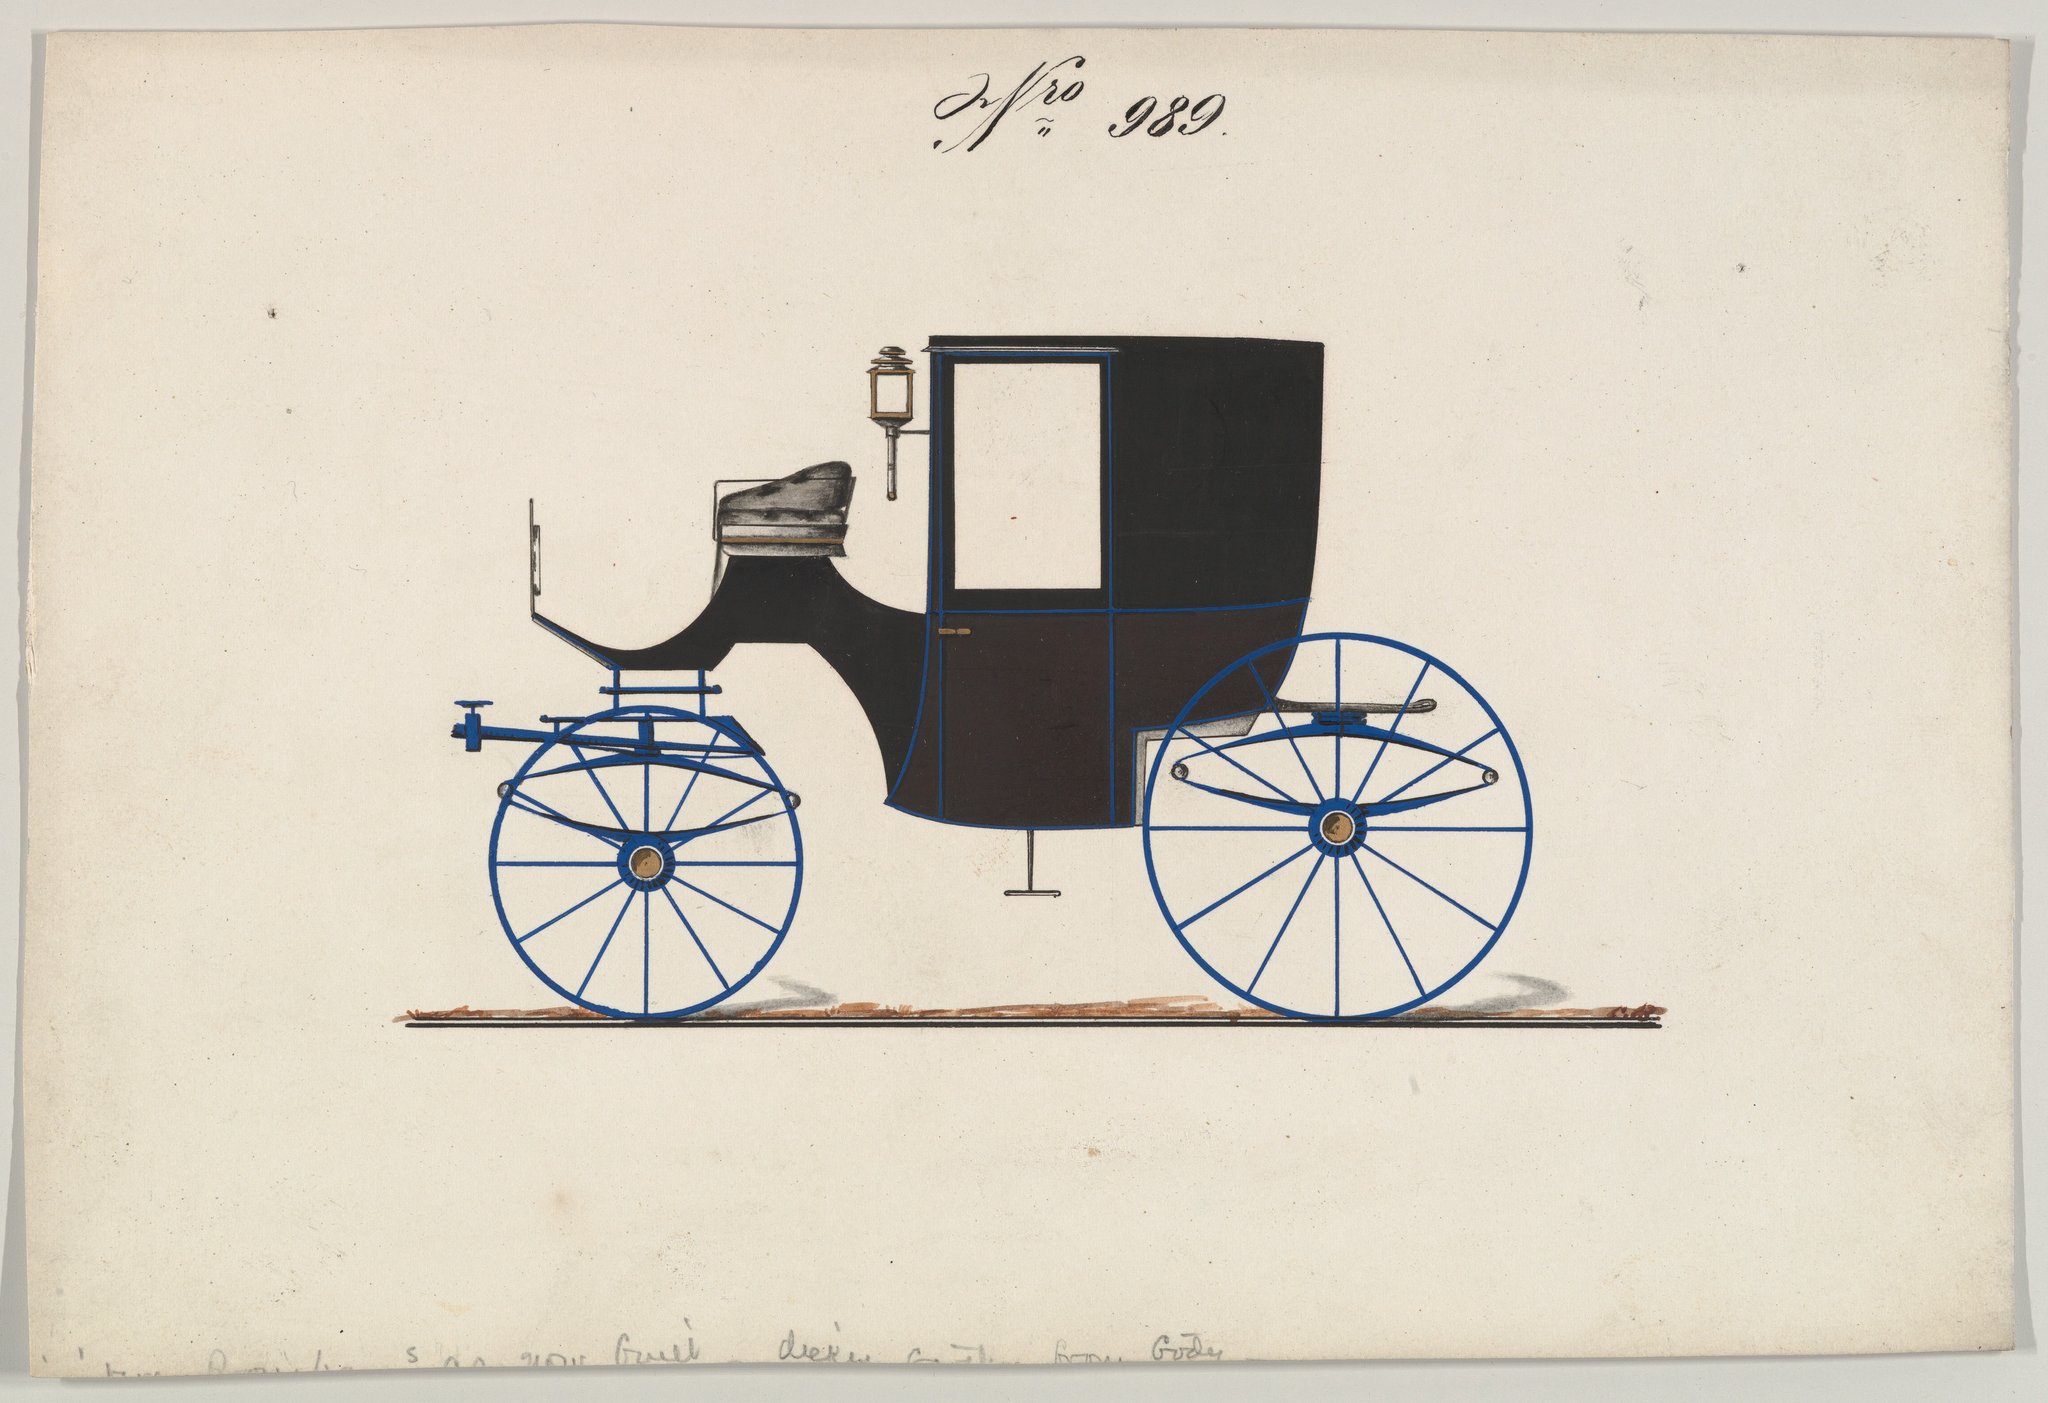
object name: drawing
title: Design for Brougham, no. 989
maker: brewster & co.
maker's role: manufacturer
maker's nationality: american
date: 1850-1870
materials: gouache, ink, watercolor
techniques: pen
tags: carriages